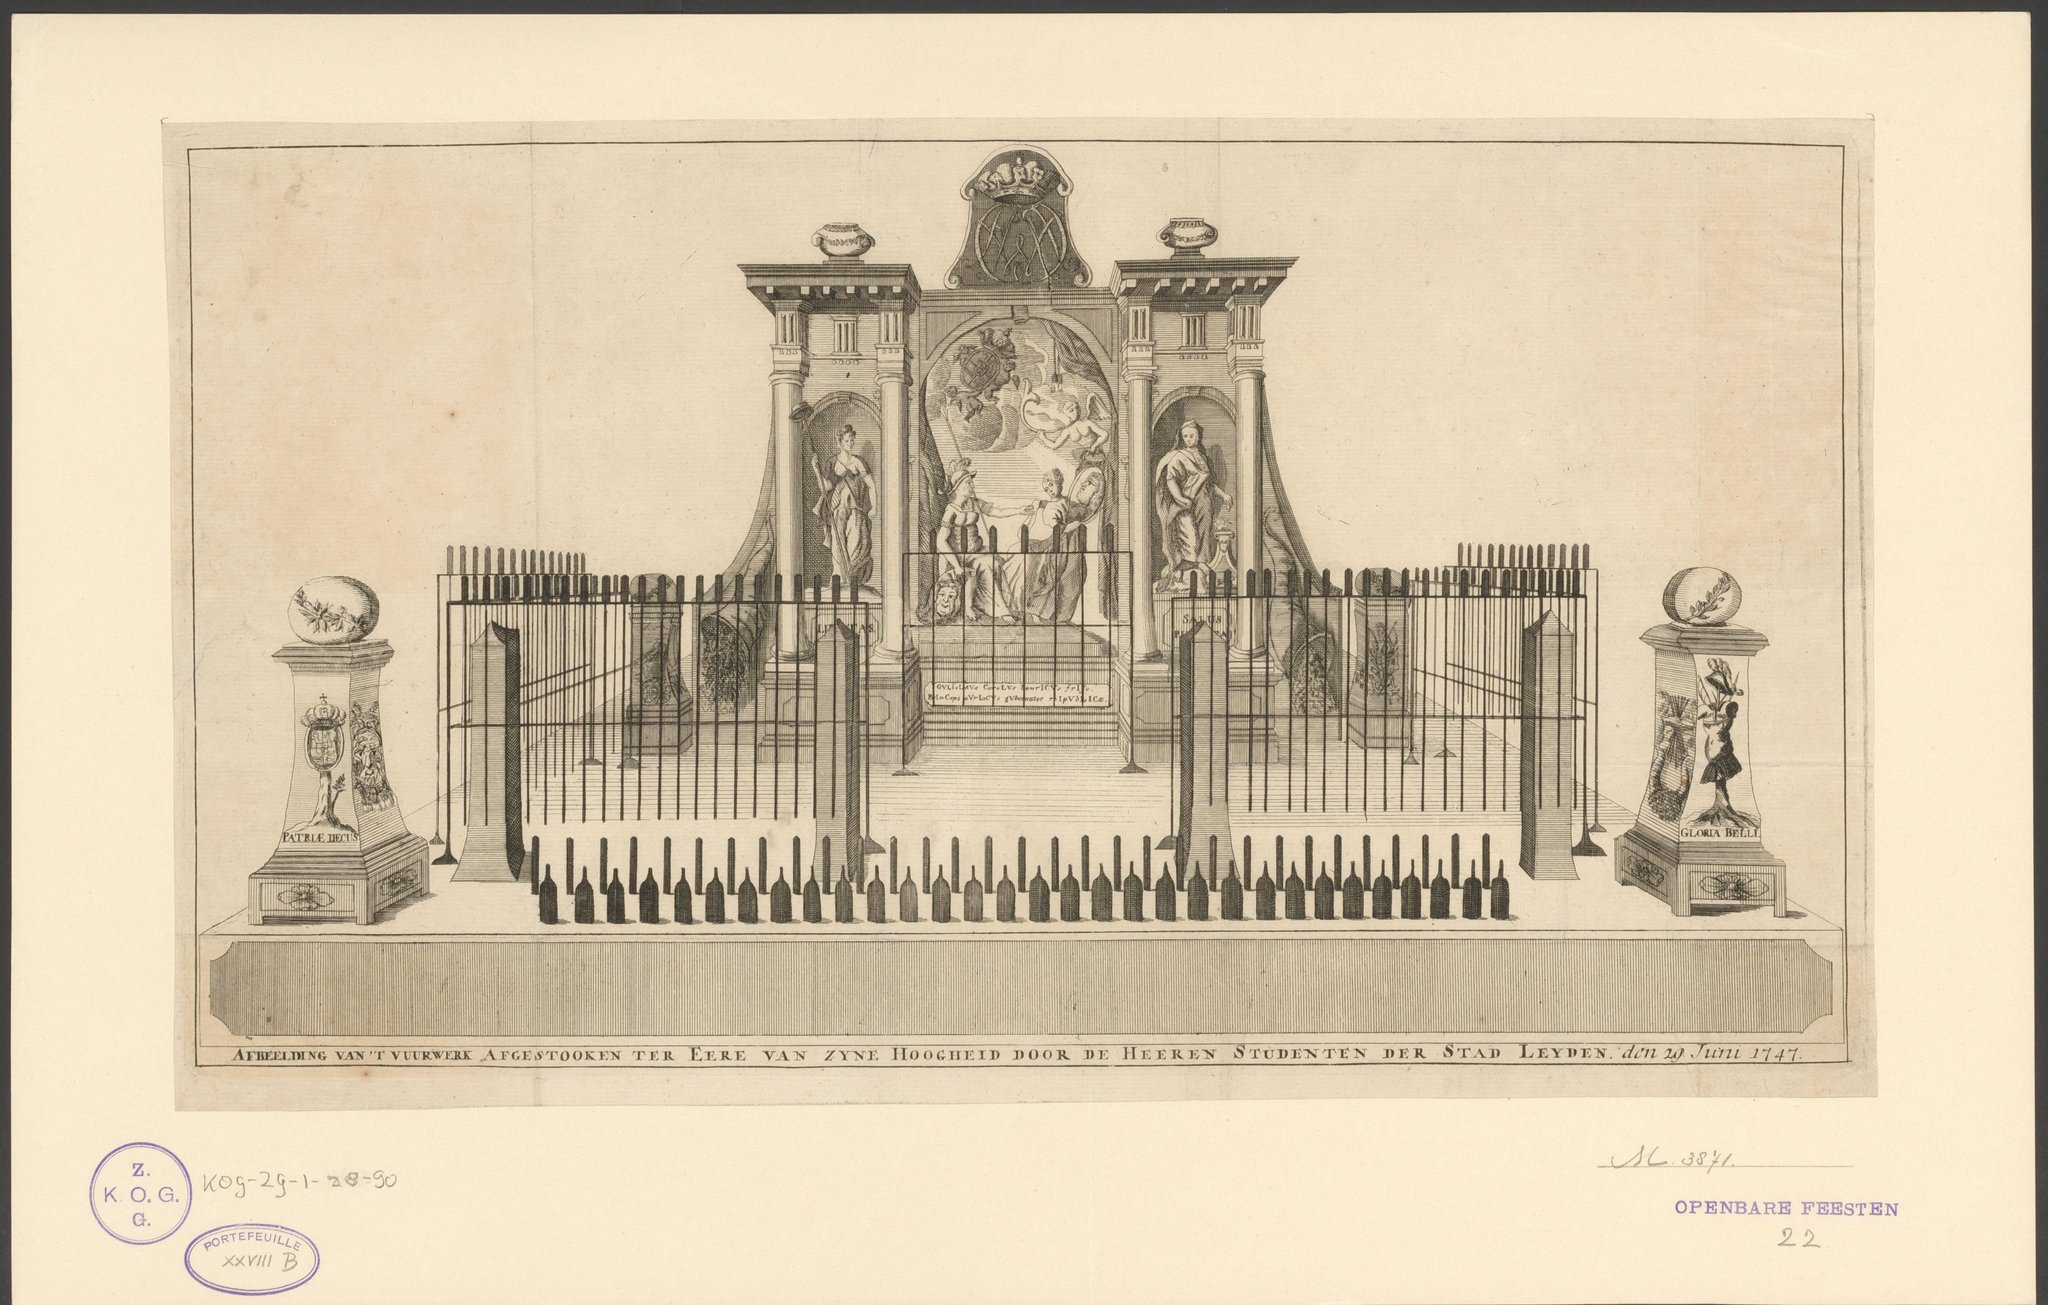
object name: print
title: Vuurwerk te Leiden bij de aanstelling van Willem IV tot stadhouder van de Republiek, 1747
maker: Anonymous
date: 1747-1749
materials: paper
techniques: etching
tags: the hague, willem iv (prins van oranje-nassau), bonfire, fire-works, leiden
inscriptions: collector's mark: Lugt 1641, stamp, stamp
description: Stellage voor het vuurwerk afgestoken in opdracht van de studenten van de Universiteit van Leiden ter ere van de aanstelling van prins Willem IV tot stadhouder van de Republiek op 29 juni 1747. Onderwerpsrubrieken binnen de Atlas Zeden en Gewoonten: Zeden en Gewoonten in Engeren Zin. Volksleven. Openbare feesten. Vorstelijke intochten, (Illuminaties, vuurwerken en dergelijke, openbare feesten).